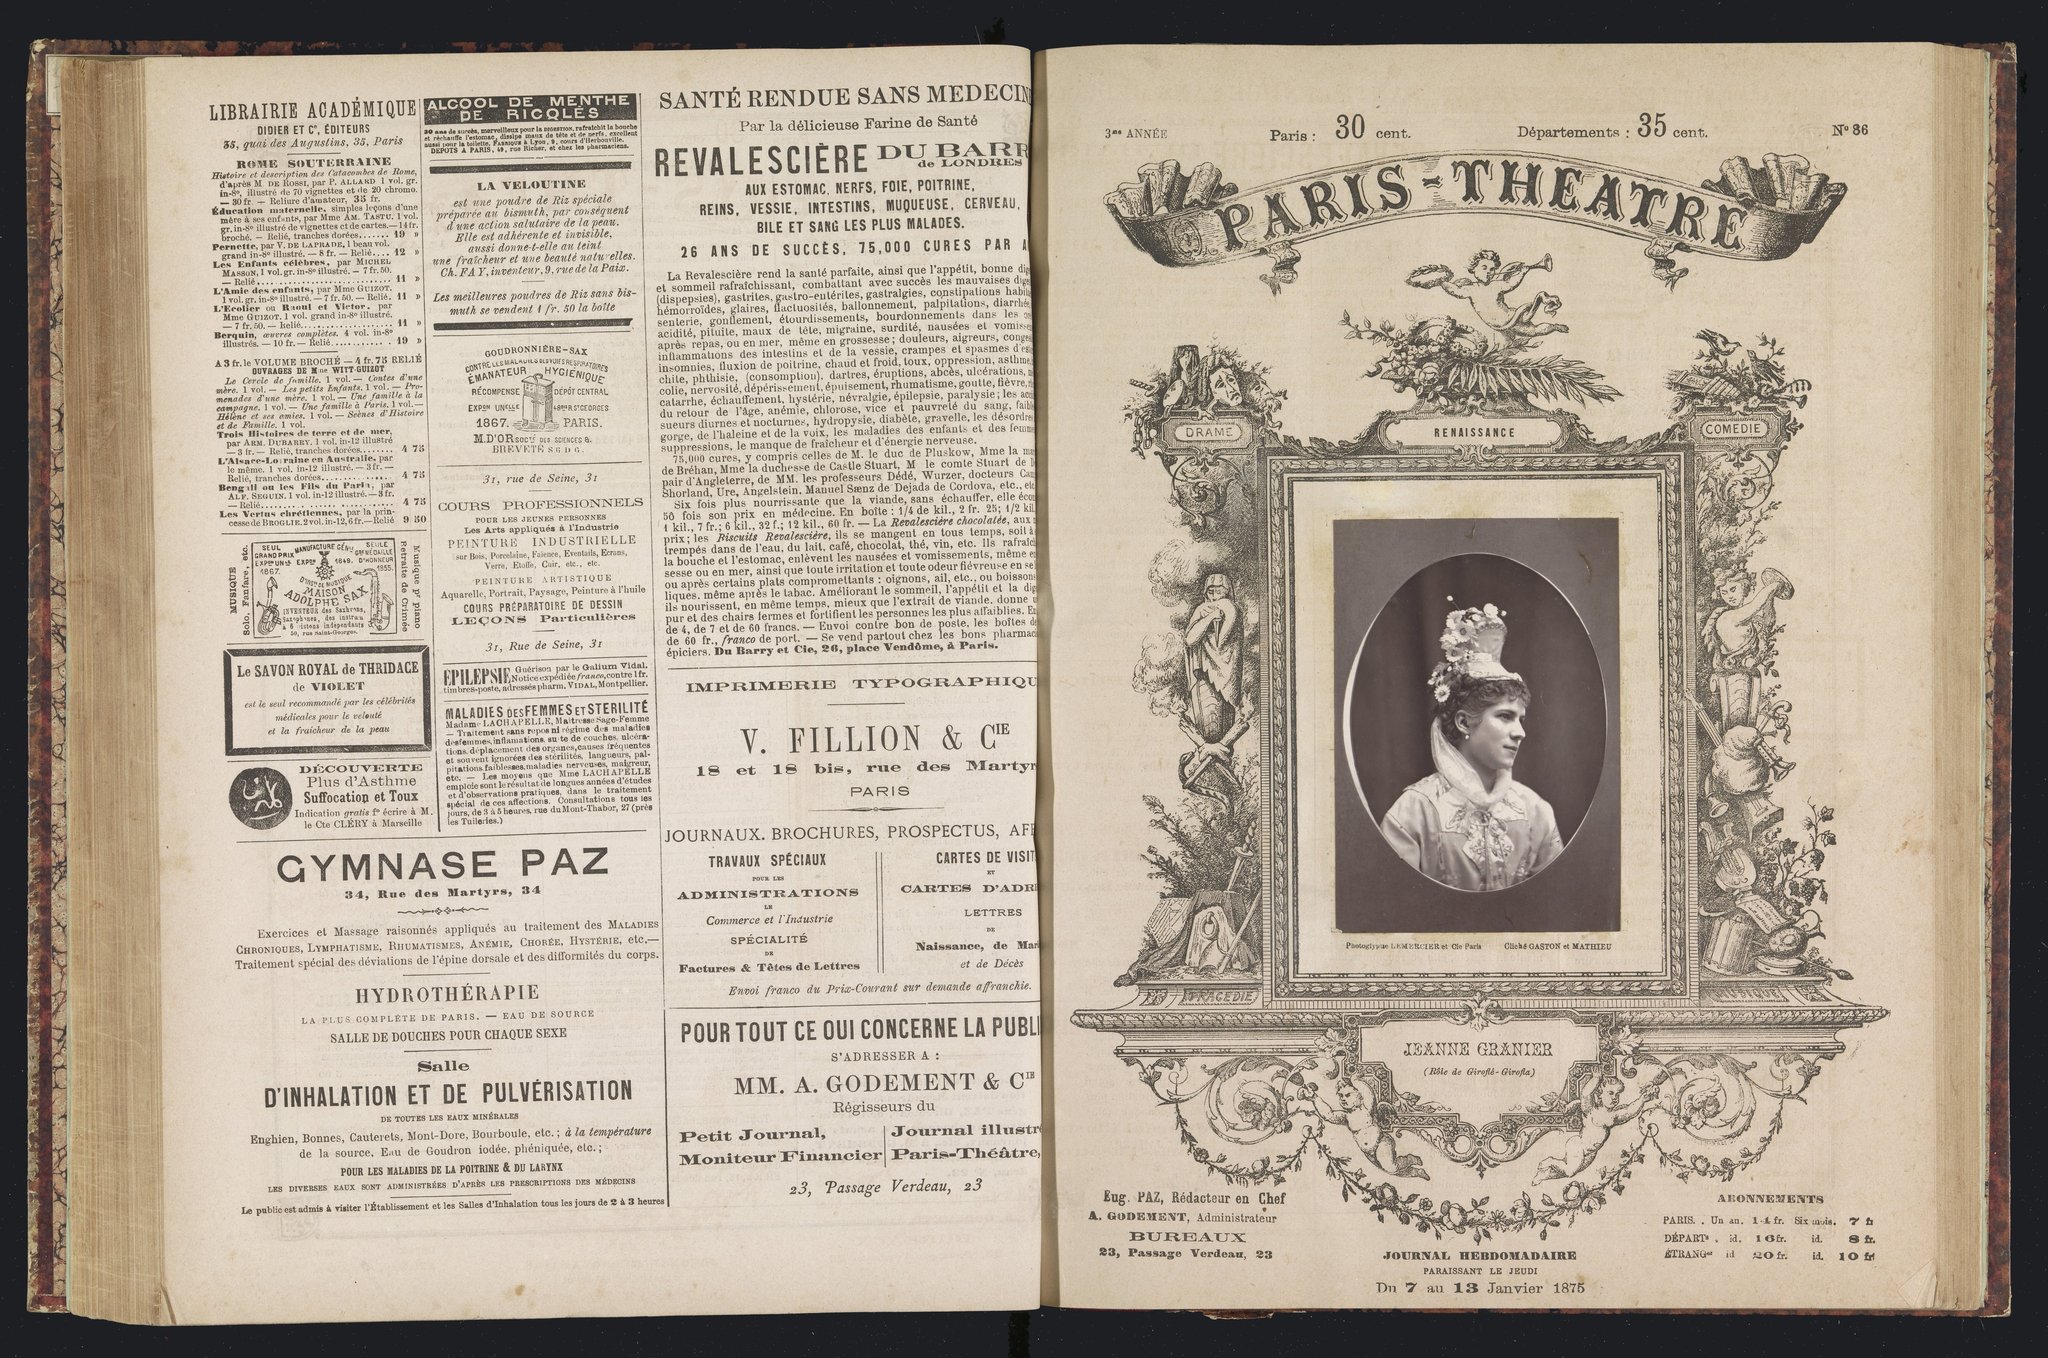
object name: photomechanical print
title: Jeanne Granier (rôle de Giroflé-Girofla)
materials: paper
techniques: woodburytype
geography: paris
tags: portrait of opera-singer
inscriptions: number: ‘No 86’, inscription: ‘Journal hebdomadaire paraissant le jeudi Du 7 au 13 Janvier 1875’